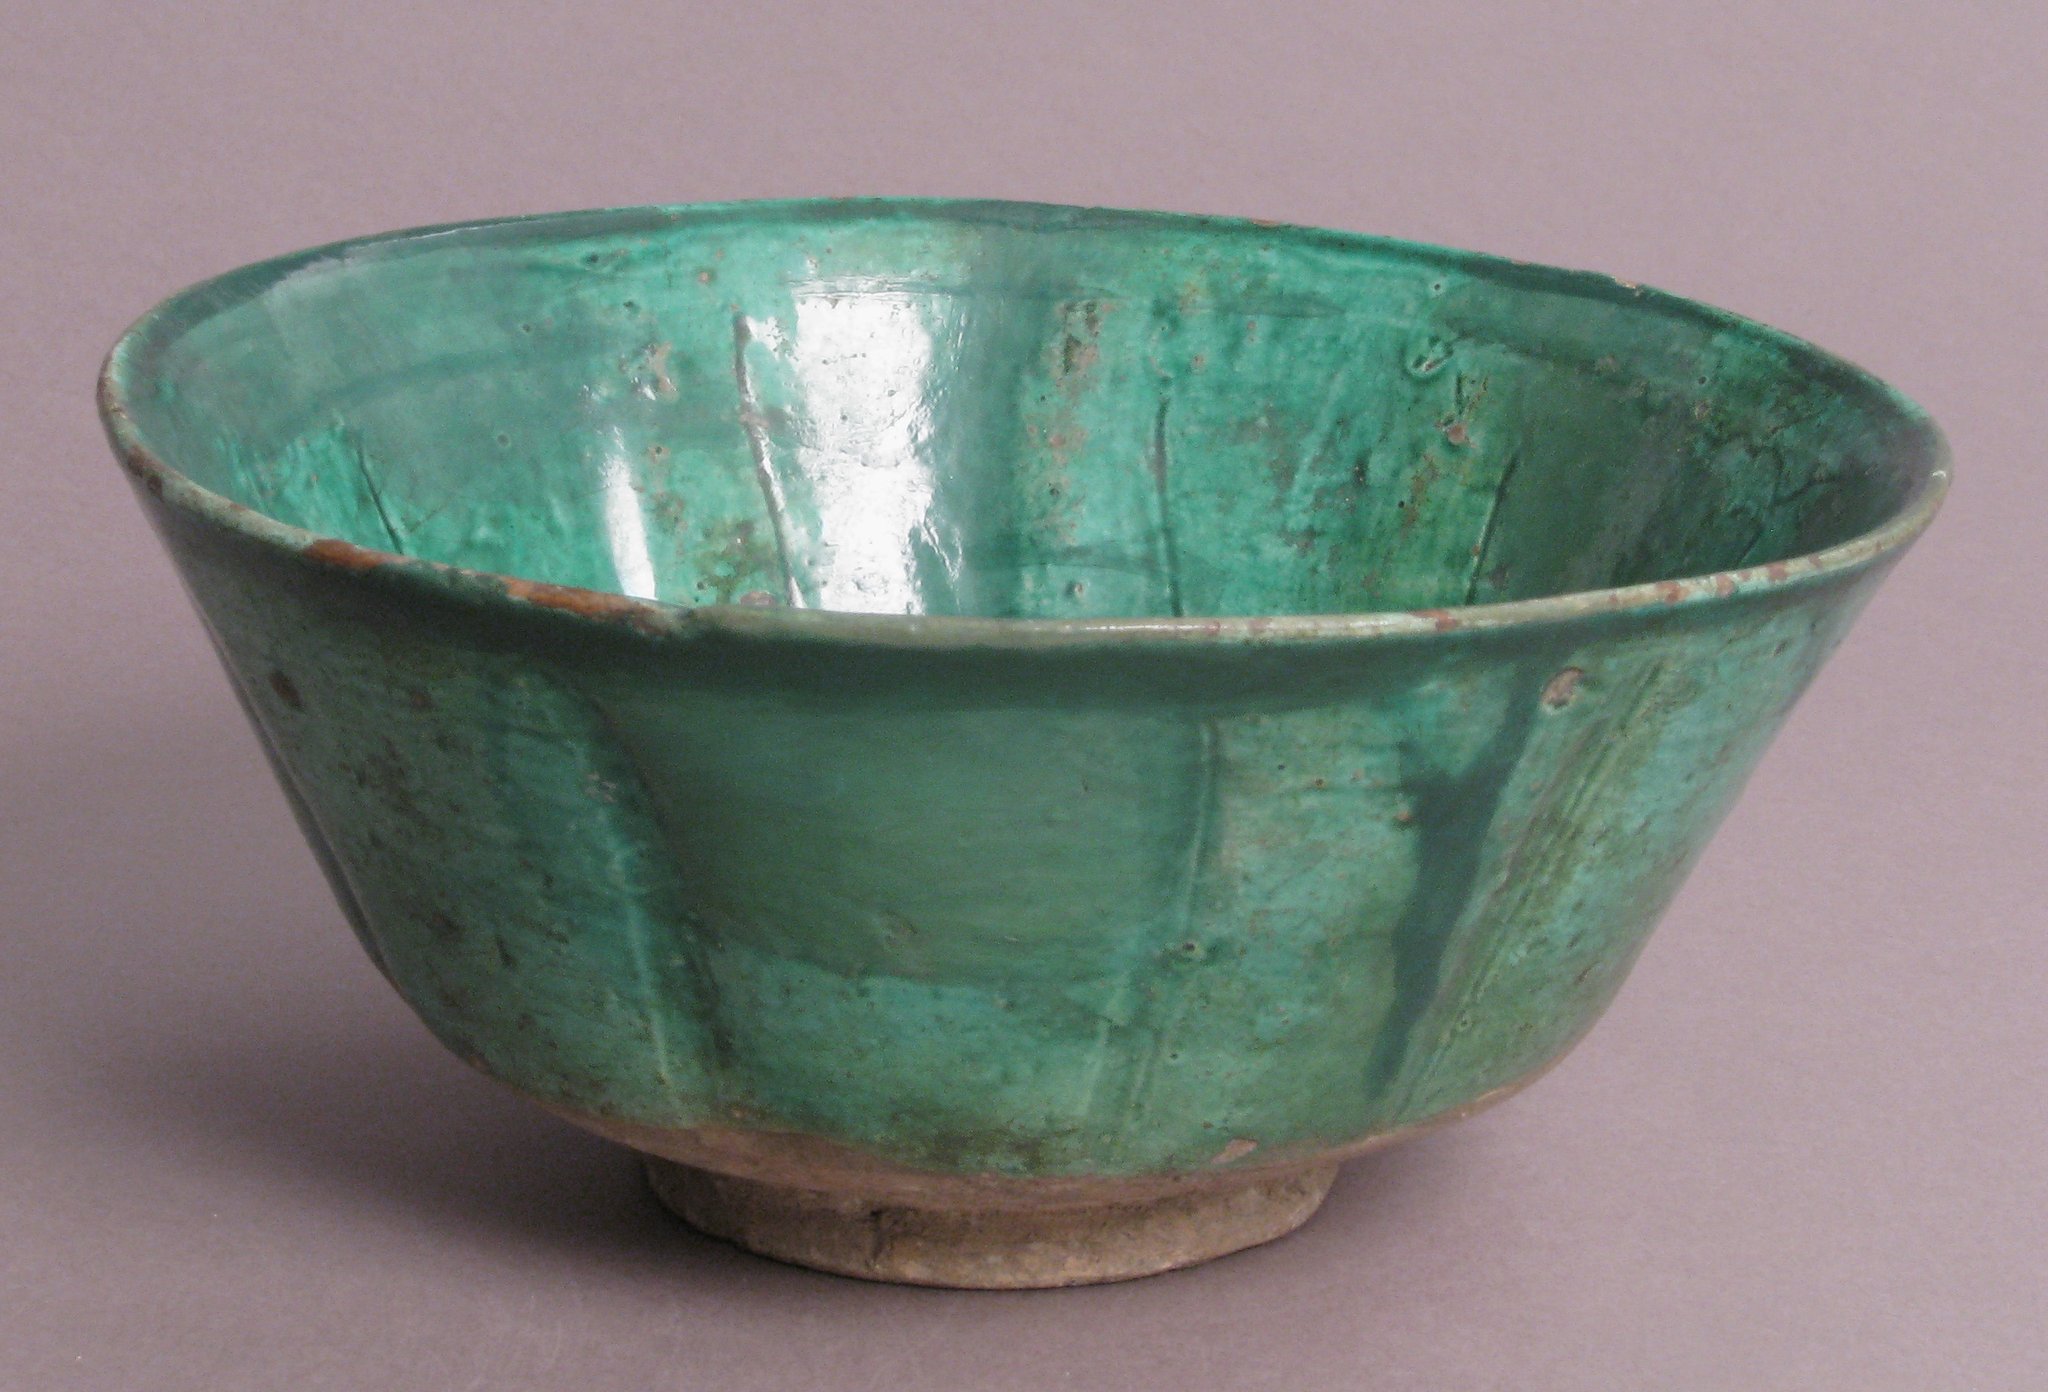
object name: bowl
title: Bowl, Fluted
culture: byzantine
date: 901-1000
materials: earthenware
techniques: glazing